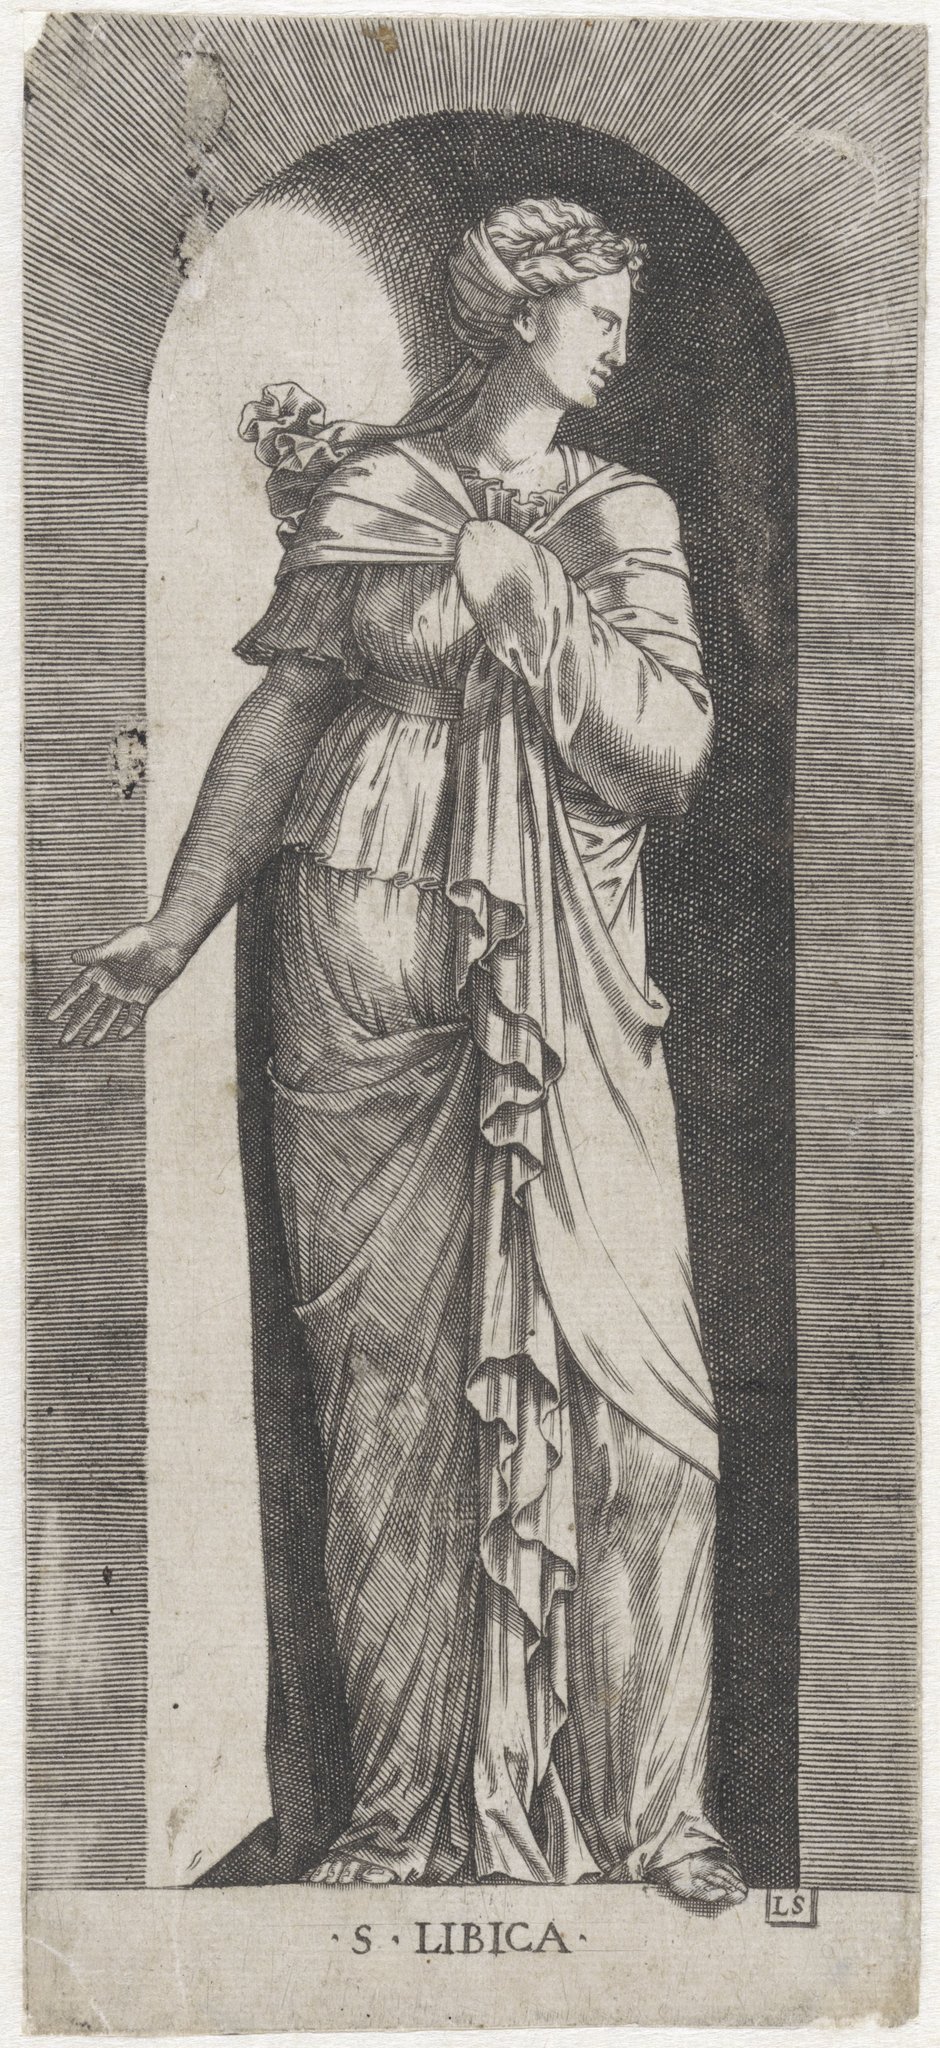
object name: print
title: S. Libica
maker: lambertus suavius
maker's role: print maker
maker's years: 1514-1564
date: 1520-1567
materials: paper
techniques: engraving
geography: southern netherlands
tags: sibyls (with name)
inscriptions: collector's mark: Lugt 2228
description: De Libische Sibille staande in een nis en de doek om haar schouders voor de borst bijeen houdend.